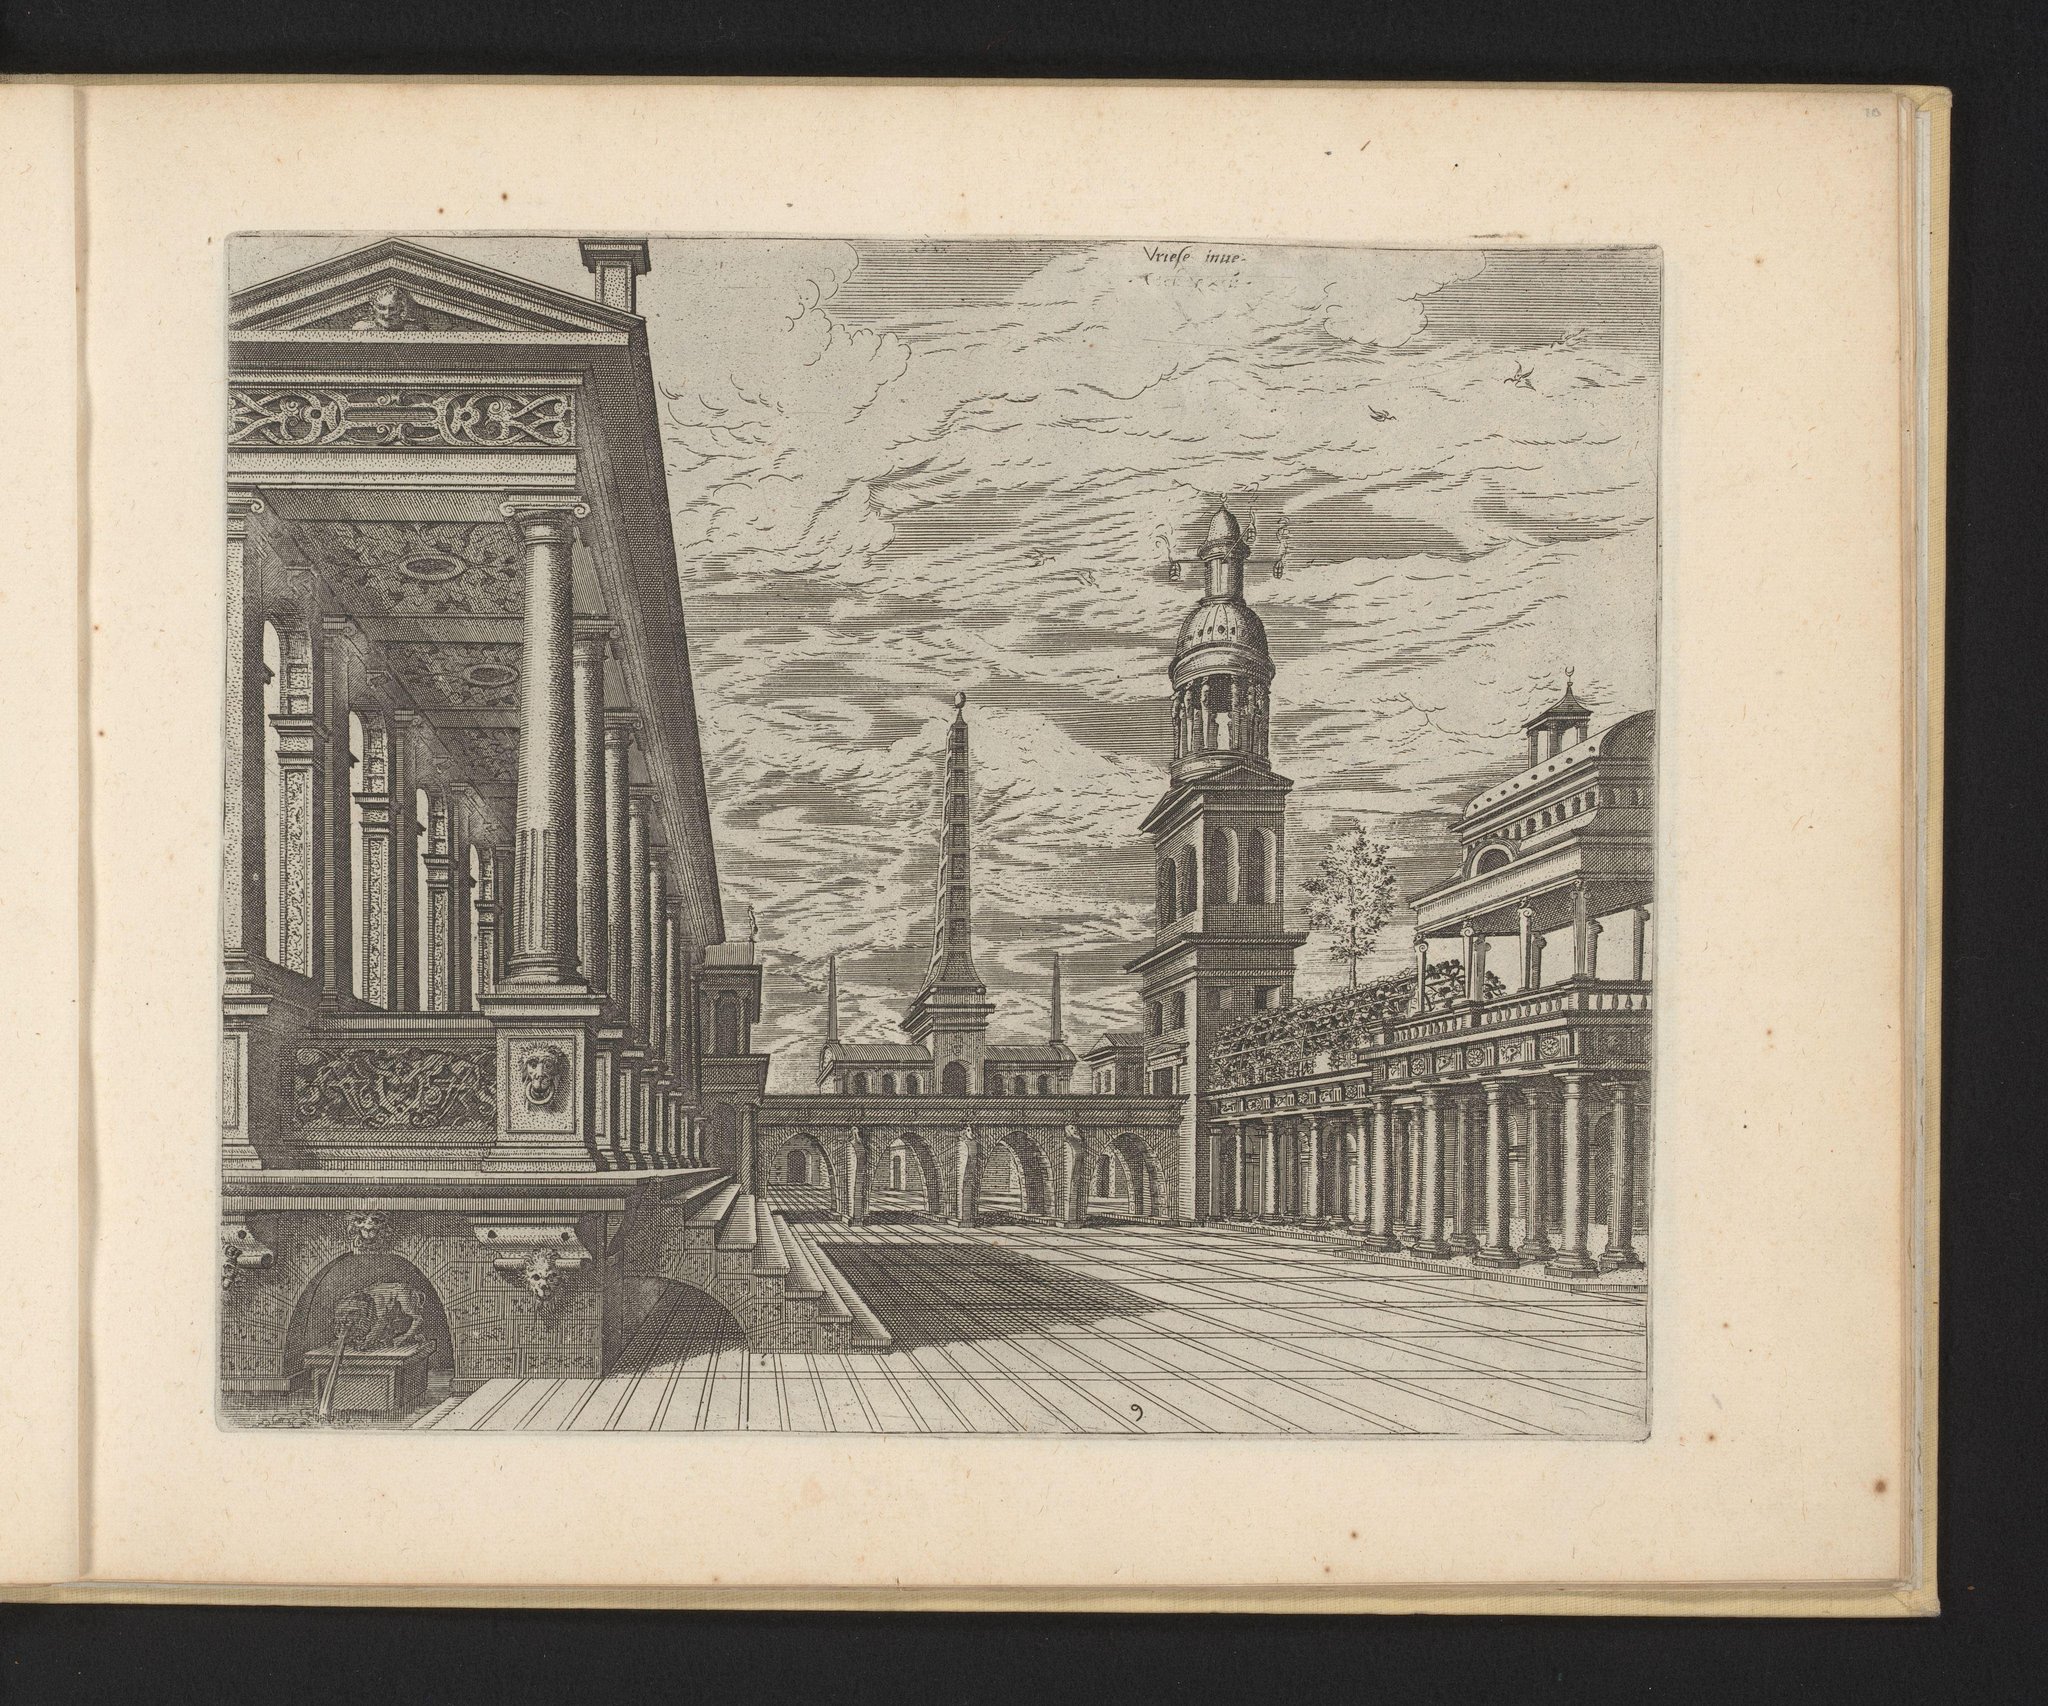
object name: album leaf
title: Variae architecturae formae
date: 1601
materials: paper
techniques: engraving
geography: antwerp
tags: village square, place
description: Stadsplein met links een verhoogde zuilengalerij. In het midden een obelisk en rechts een toren. De prent maakt deel uit van een album.